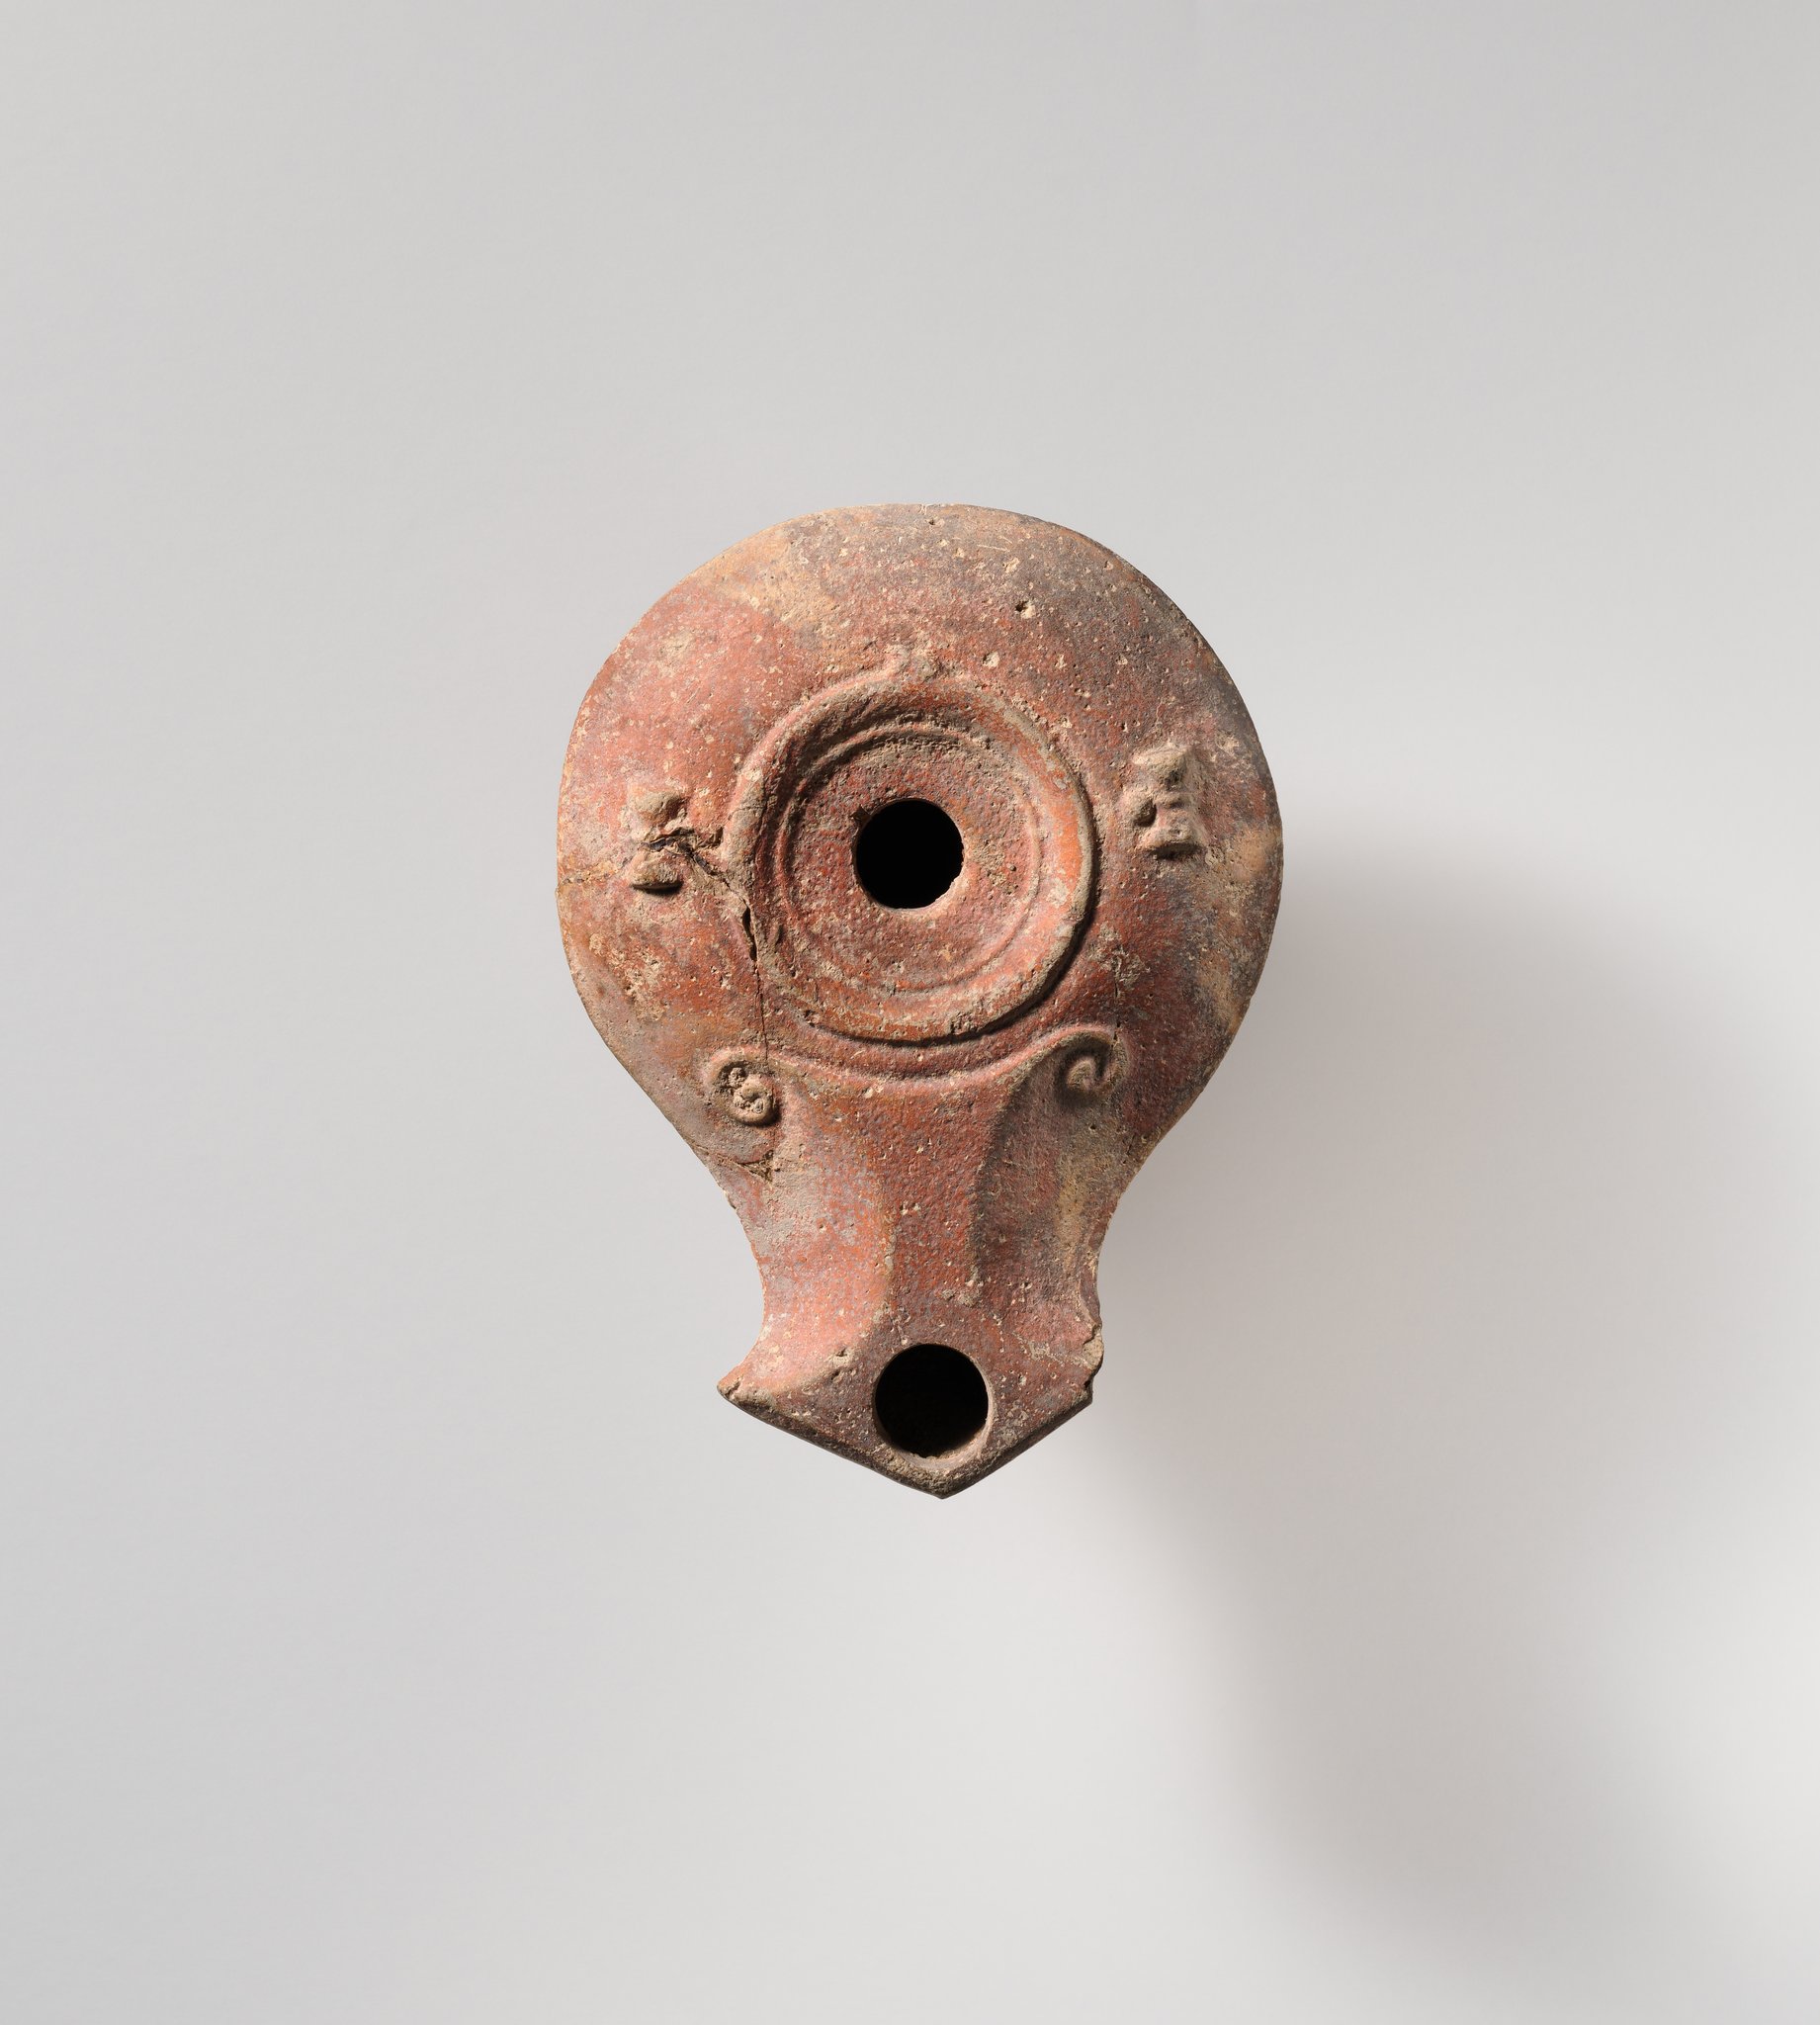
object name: lamp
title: Terracotta oil lamp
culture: greek or roman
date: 34 BCE-33 CE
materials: terracotta